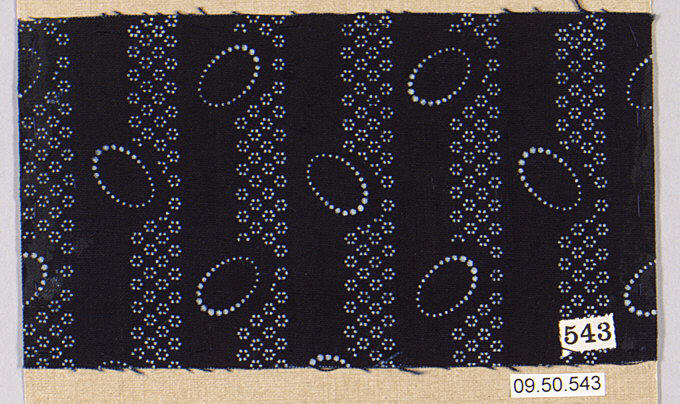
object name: piece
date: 1801-1900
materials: cotton